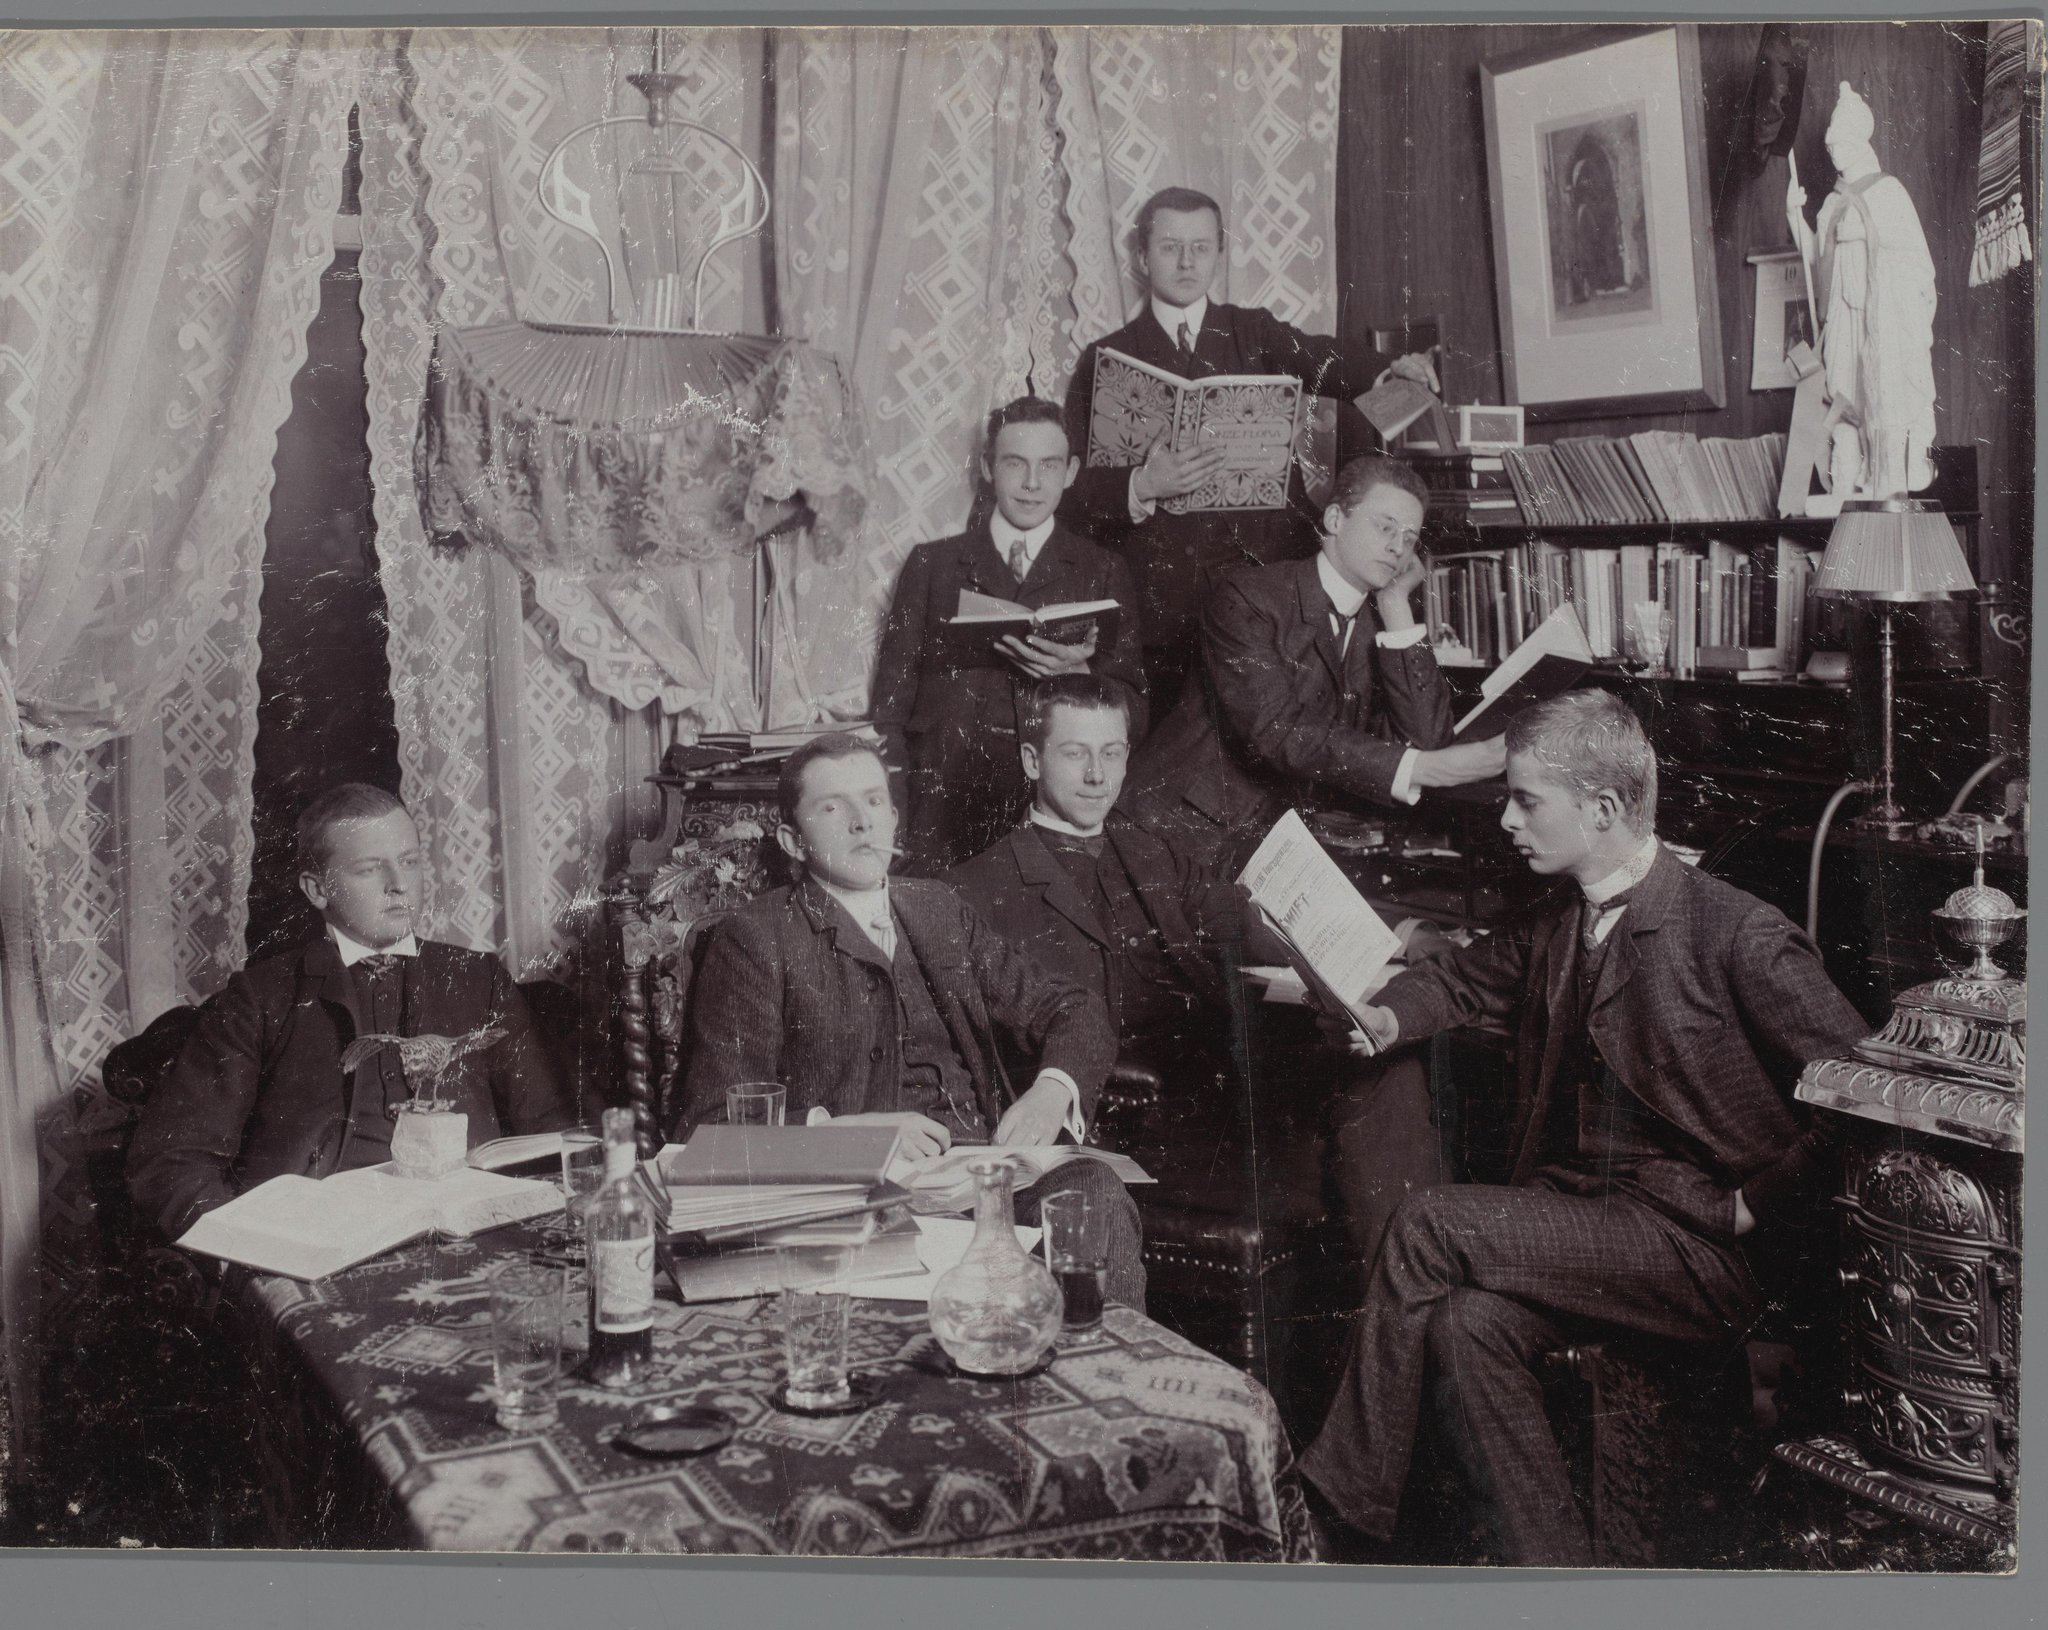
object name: photograph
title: Portret van lezende studenten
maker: Anonymous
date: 1905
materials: photographic support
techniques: collodion silver print